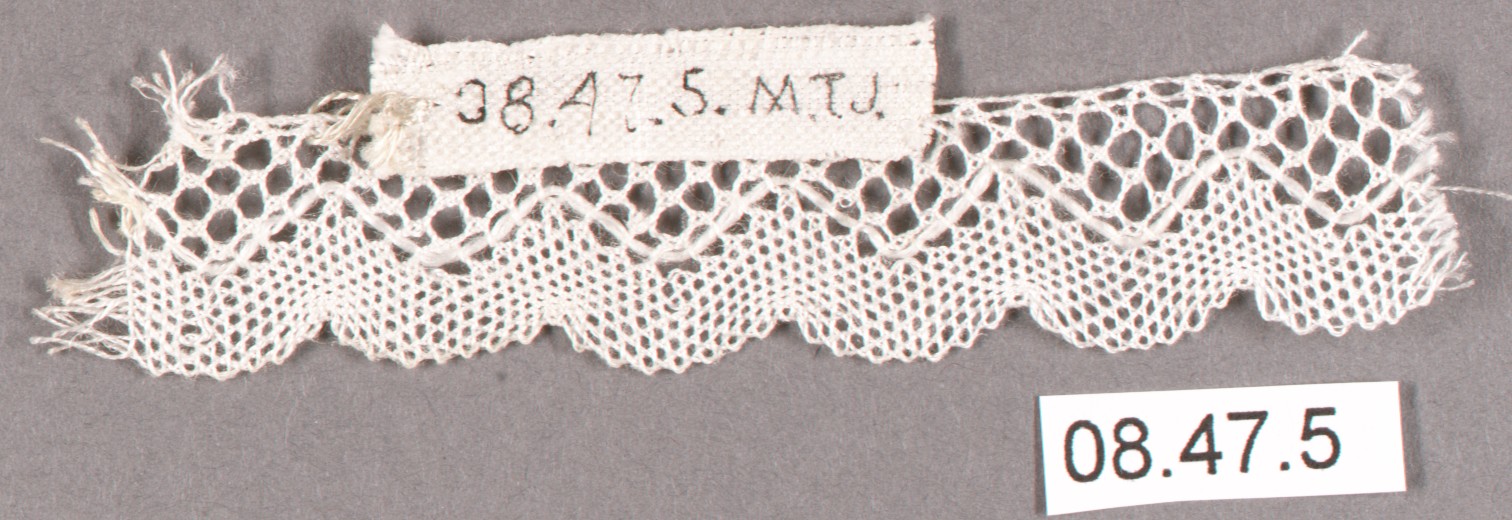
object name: fragment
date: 1801-1900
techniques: lace